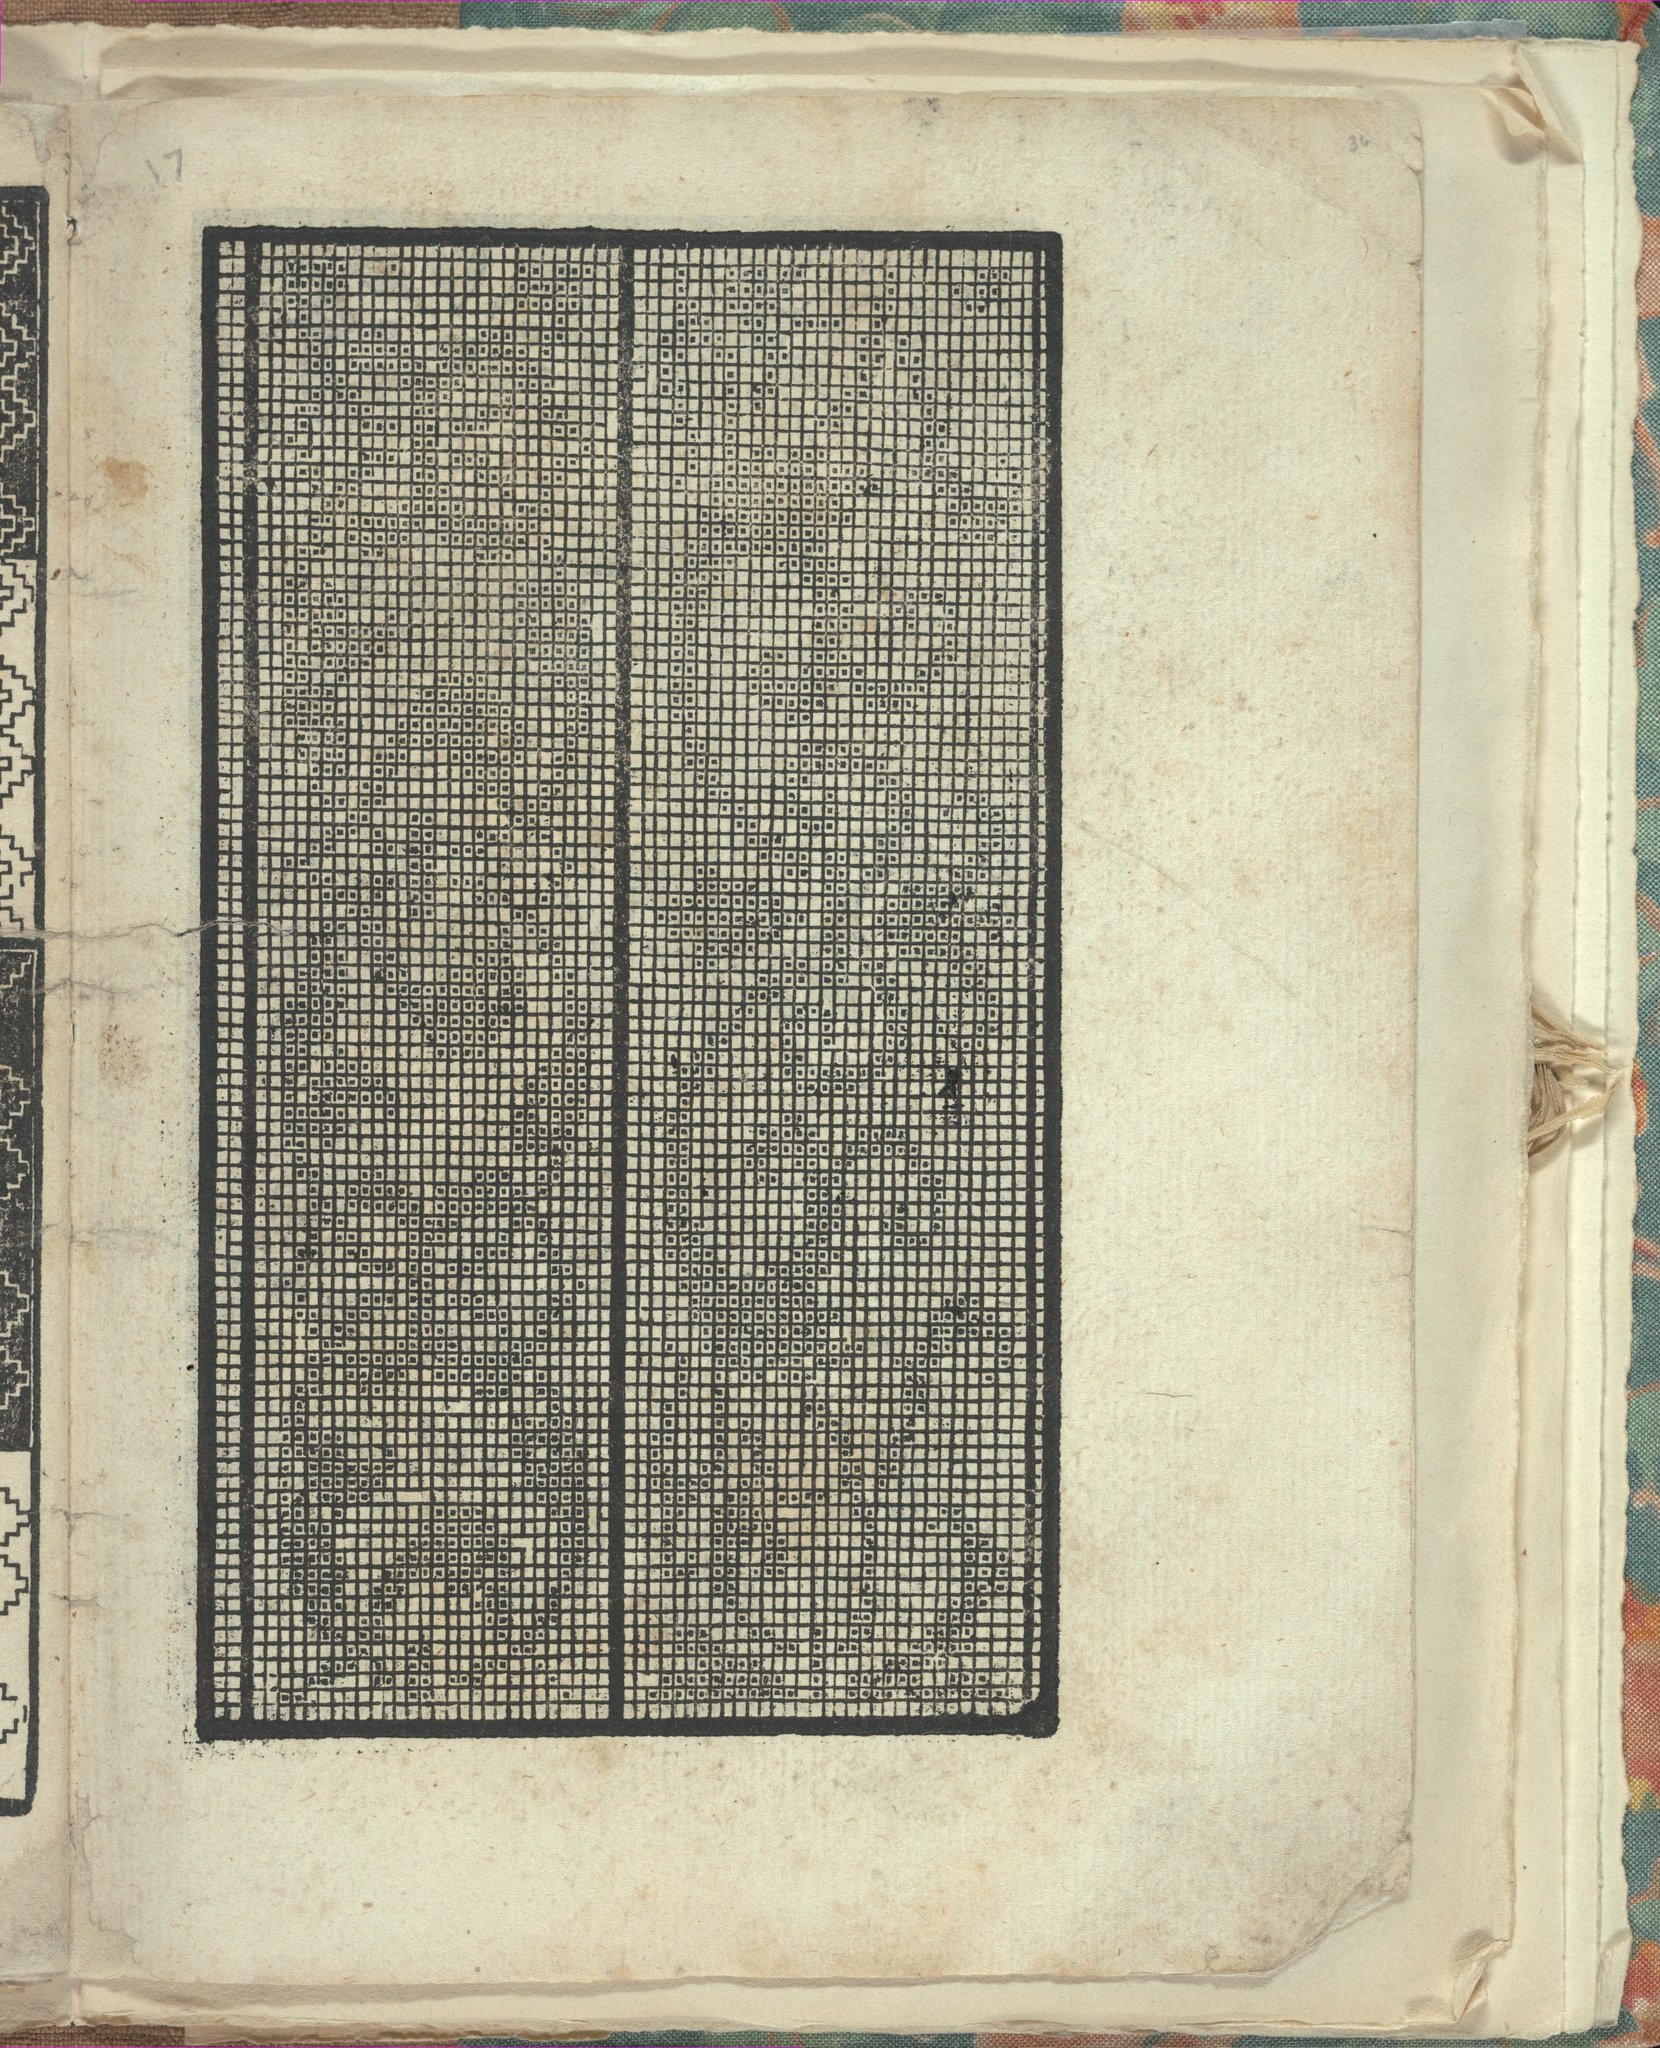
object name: book print ornament architecture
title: Opera Nova Universali intitulata Corona di racammi, page 36 (recto)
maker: giovanni andrea vavassore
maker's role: publisher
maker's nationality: italian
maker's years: 1530-1573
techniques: woodcut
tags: ornament